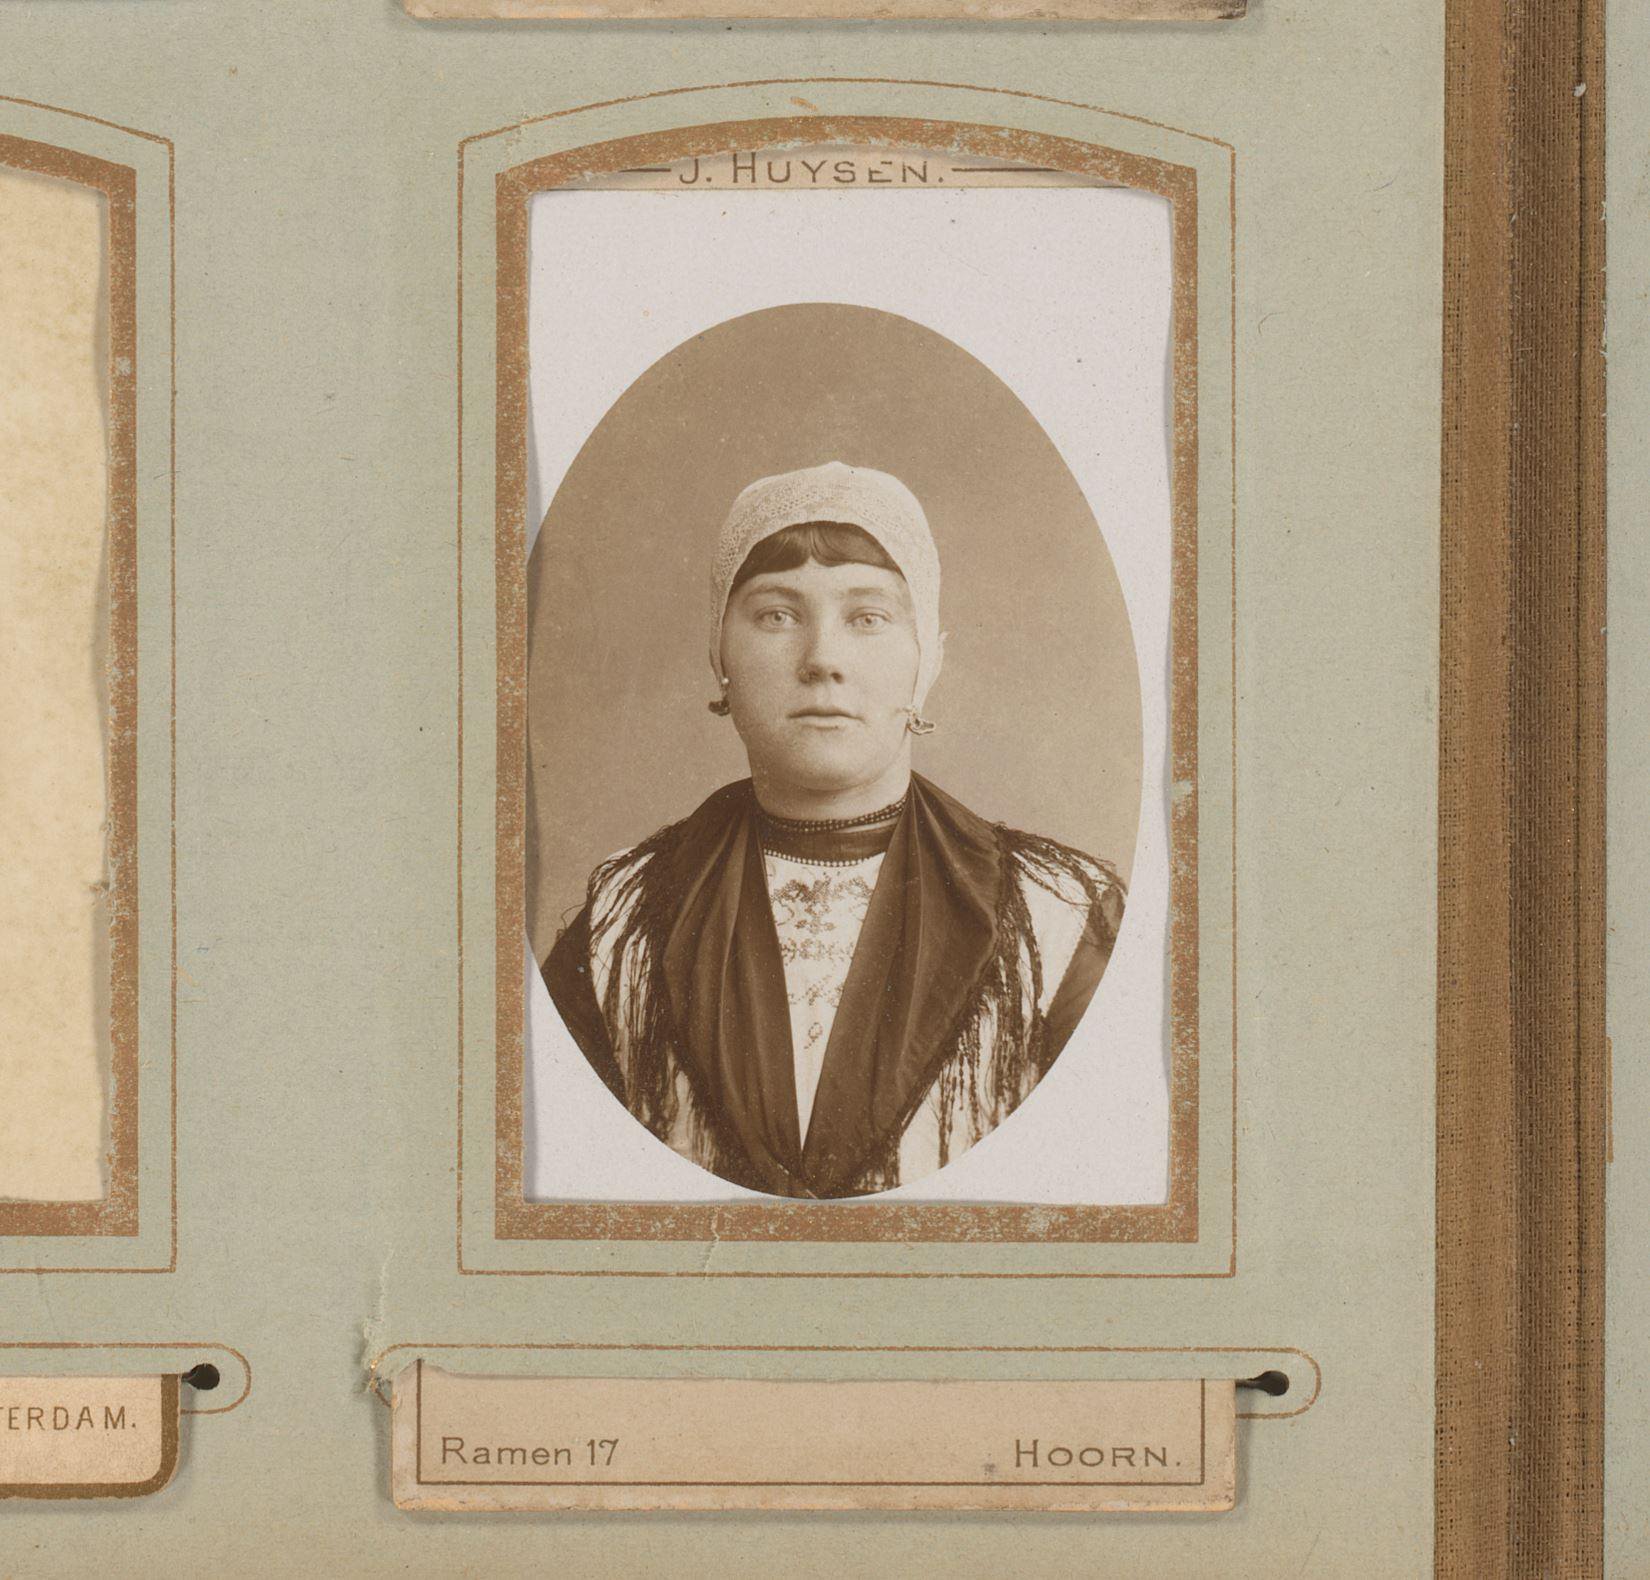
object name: photograph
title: Portret van een vrouw met West-Friese klederdrachtmuts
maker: johannes laurens theodorus huijsen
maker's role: fotograaf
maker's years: 1852-1910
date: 1883-1910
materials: cardboard, photographic support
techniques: collodion silver print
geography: hoorn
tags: historical persons - bb - woman, head-gear: cap, folk costume, regional costume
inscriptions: inscription: ‘J.L.T. Huysen/ Photograaf/ Ramen 17./ Hoorn/ Specialiteit in Kooldruck Vergrootingen/ OPNAME OOK BUITEN HET ATELIER.’